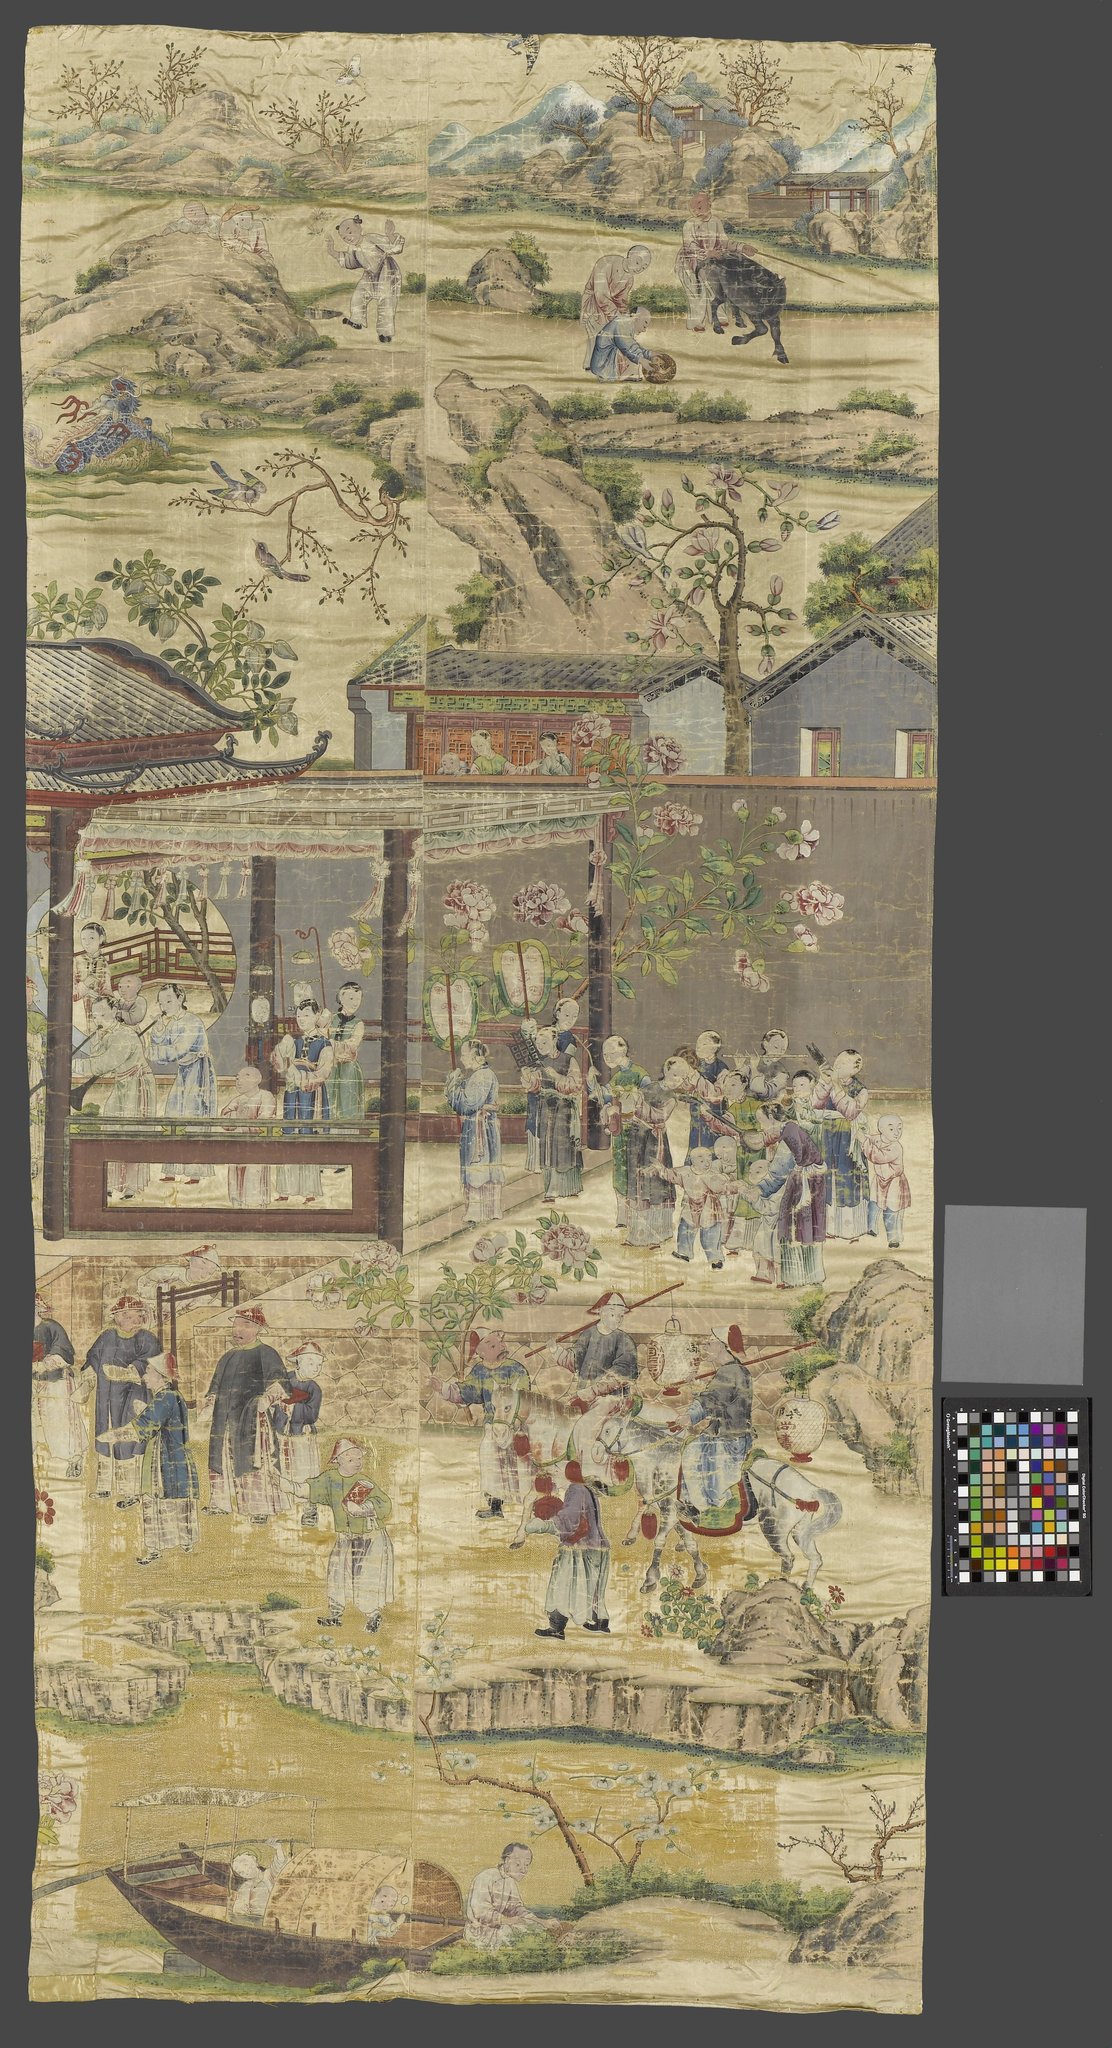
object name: upholstered wall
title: Fragment van een wandbespanning met Chinese genre-taferelen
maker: Anonymous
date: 1775-1790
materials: textile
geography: china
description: Fragment van een wandbespanning met Chinese genre-taferelen. Op de voorgrond een jank met bemanning. Op de rotsachtige oever vier mannen en twee jongens, naar links gaande, gekleed in donker overgewaad en kegelvormige witte hoed met rode kwast en gevolgd door vier mannen waarvan twee te paard. Op het middenplan een terras met rode galerij, waarin vrouwen met bazuinen en lampions naar links gaan, gevolgd door vrouwen en kinderen met pajengs en muziekinstrumenten. Over een muur kijken drie Chineesjes. Achtergrond met bloeiende struiken en met rotsen, waarop links een kijlin met dondermotieven, rechts wordt een karbouw voortgedreven en spelen kinderen met een bal (egel ?). Verschiet met bergtoppen en huizen. In de lucht een vogel.